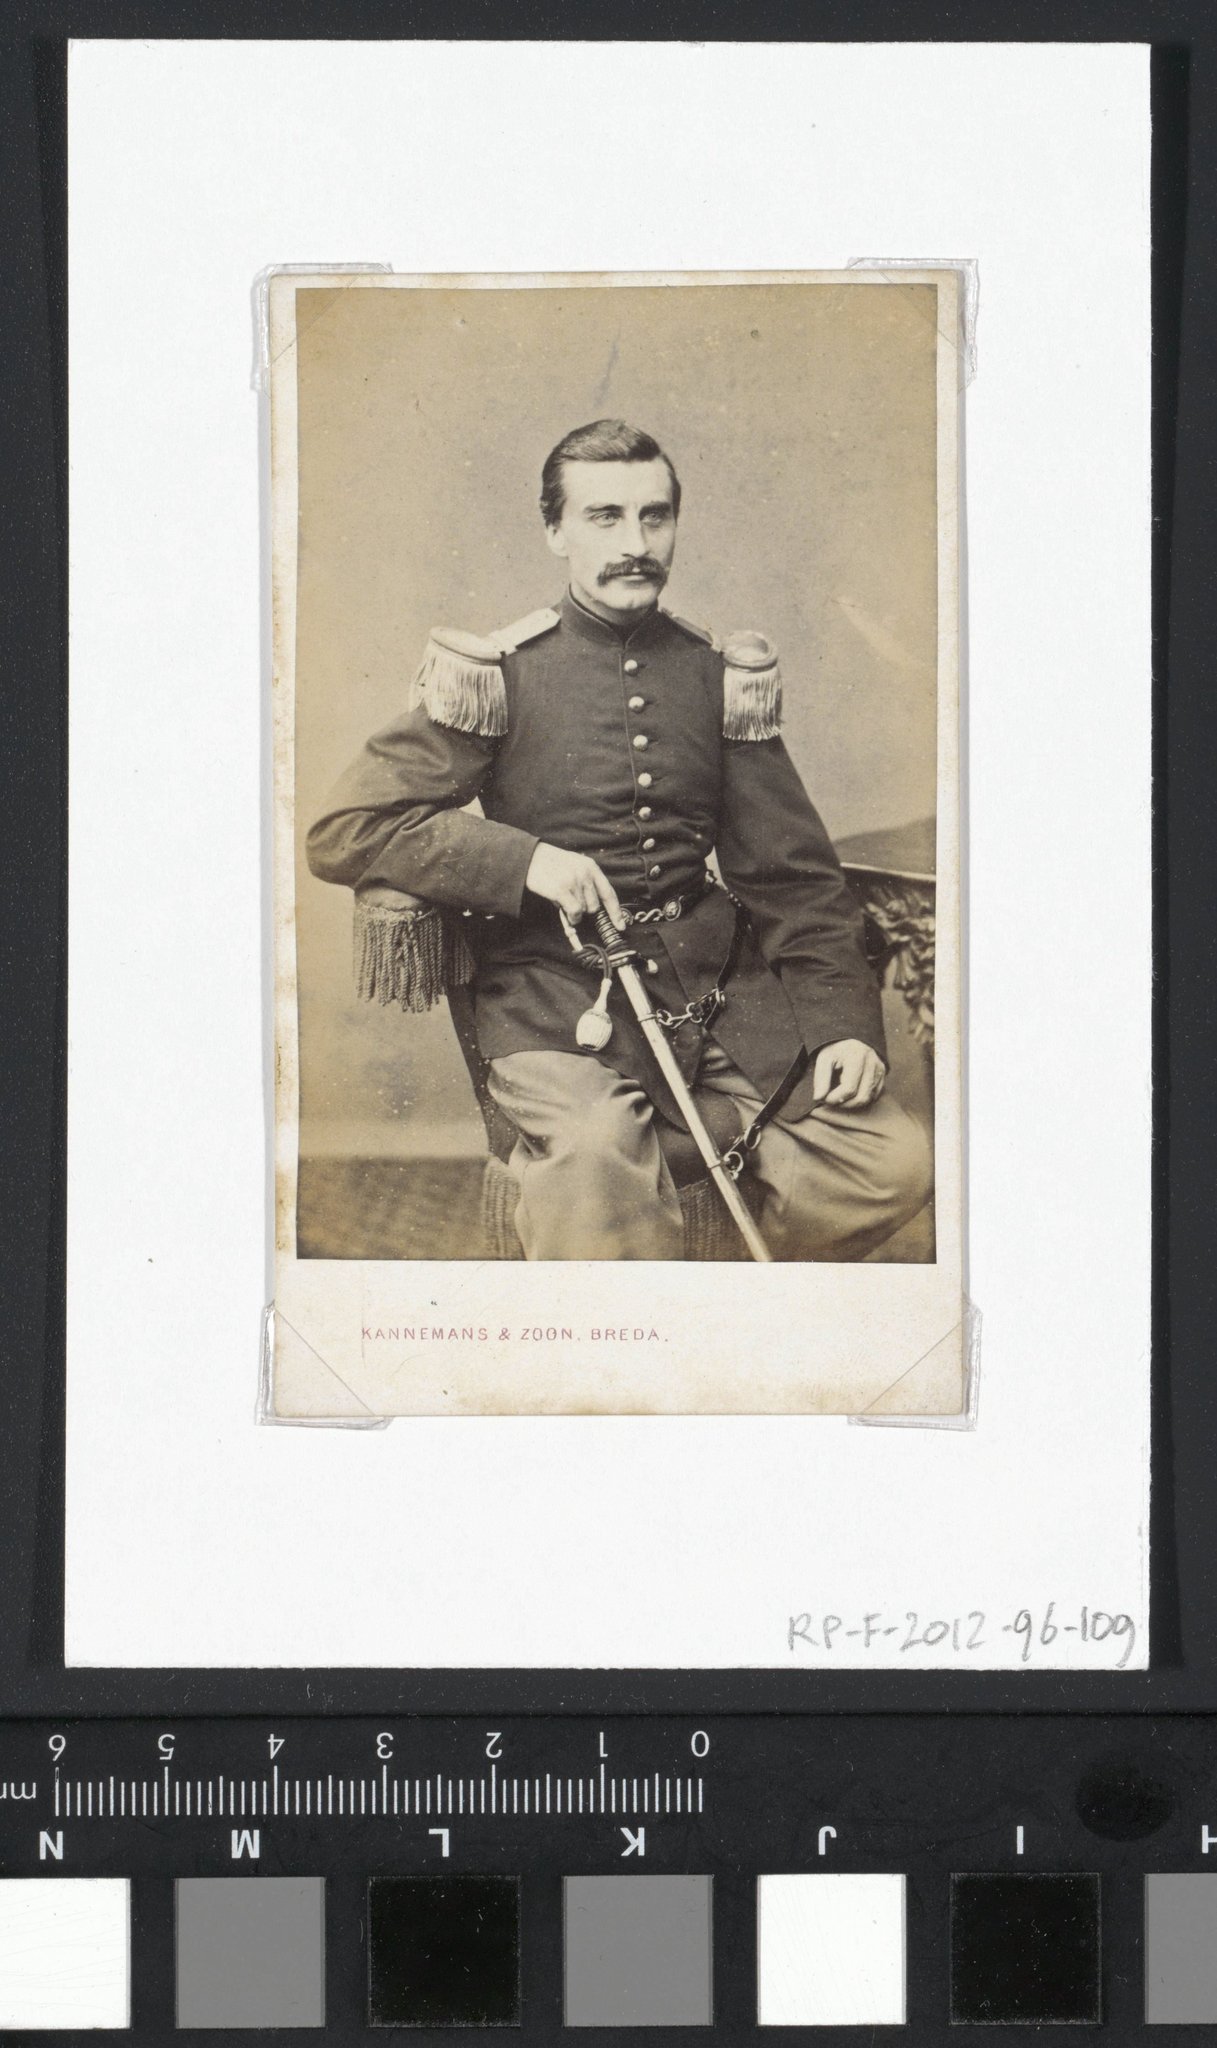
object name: photograph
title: Portret van Abraham Pompe in militair uniform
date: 1860-1884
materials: cardboard, paper, photographic support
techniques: albumen print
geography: breda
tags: studio requisites ~ photographer, historical persons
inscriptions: inscription: ‘Souvenir A. Pompe’, address: ‘Breda Groote Markt D.15 tegen over het stadhuis’